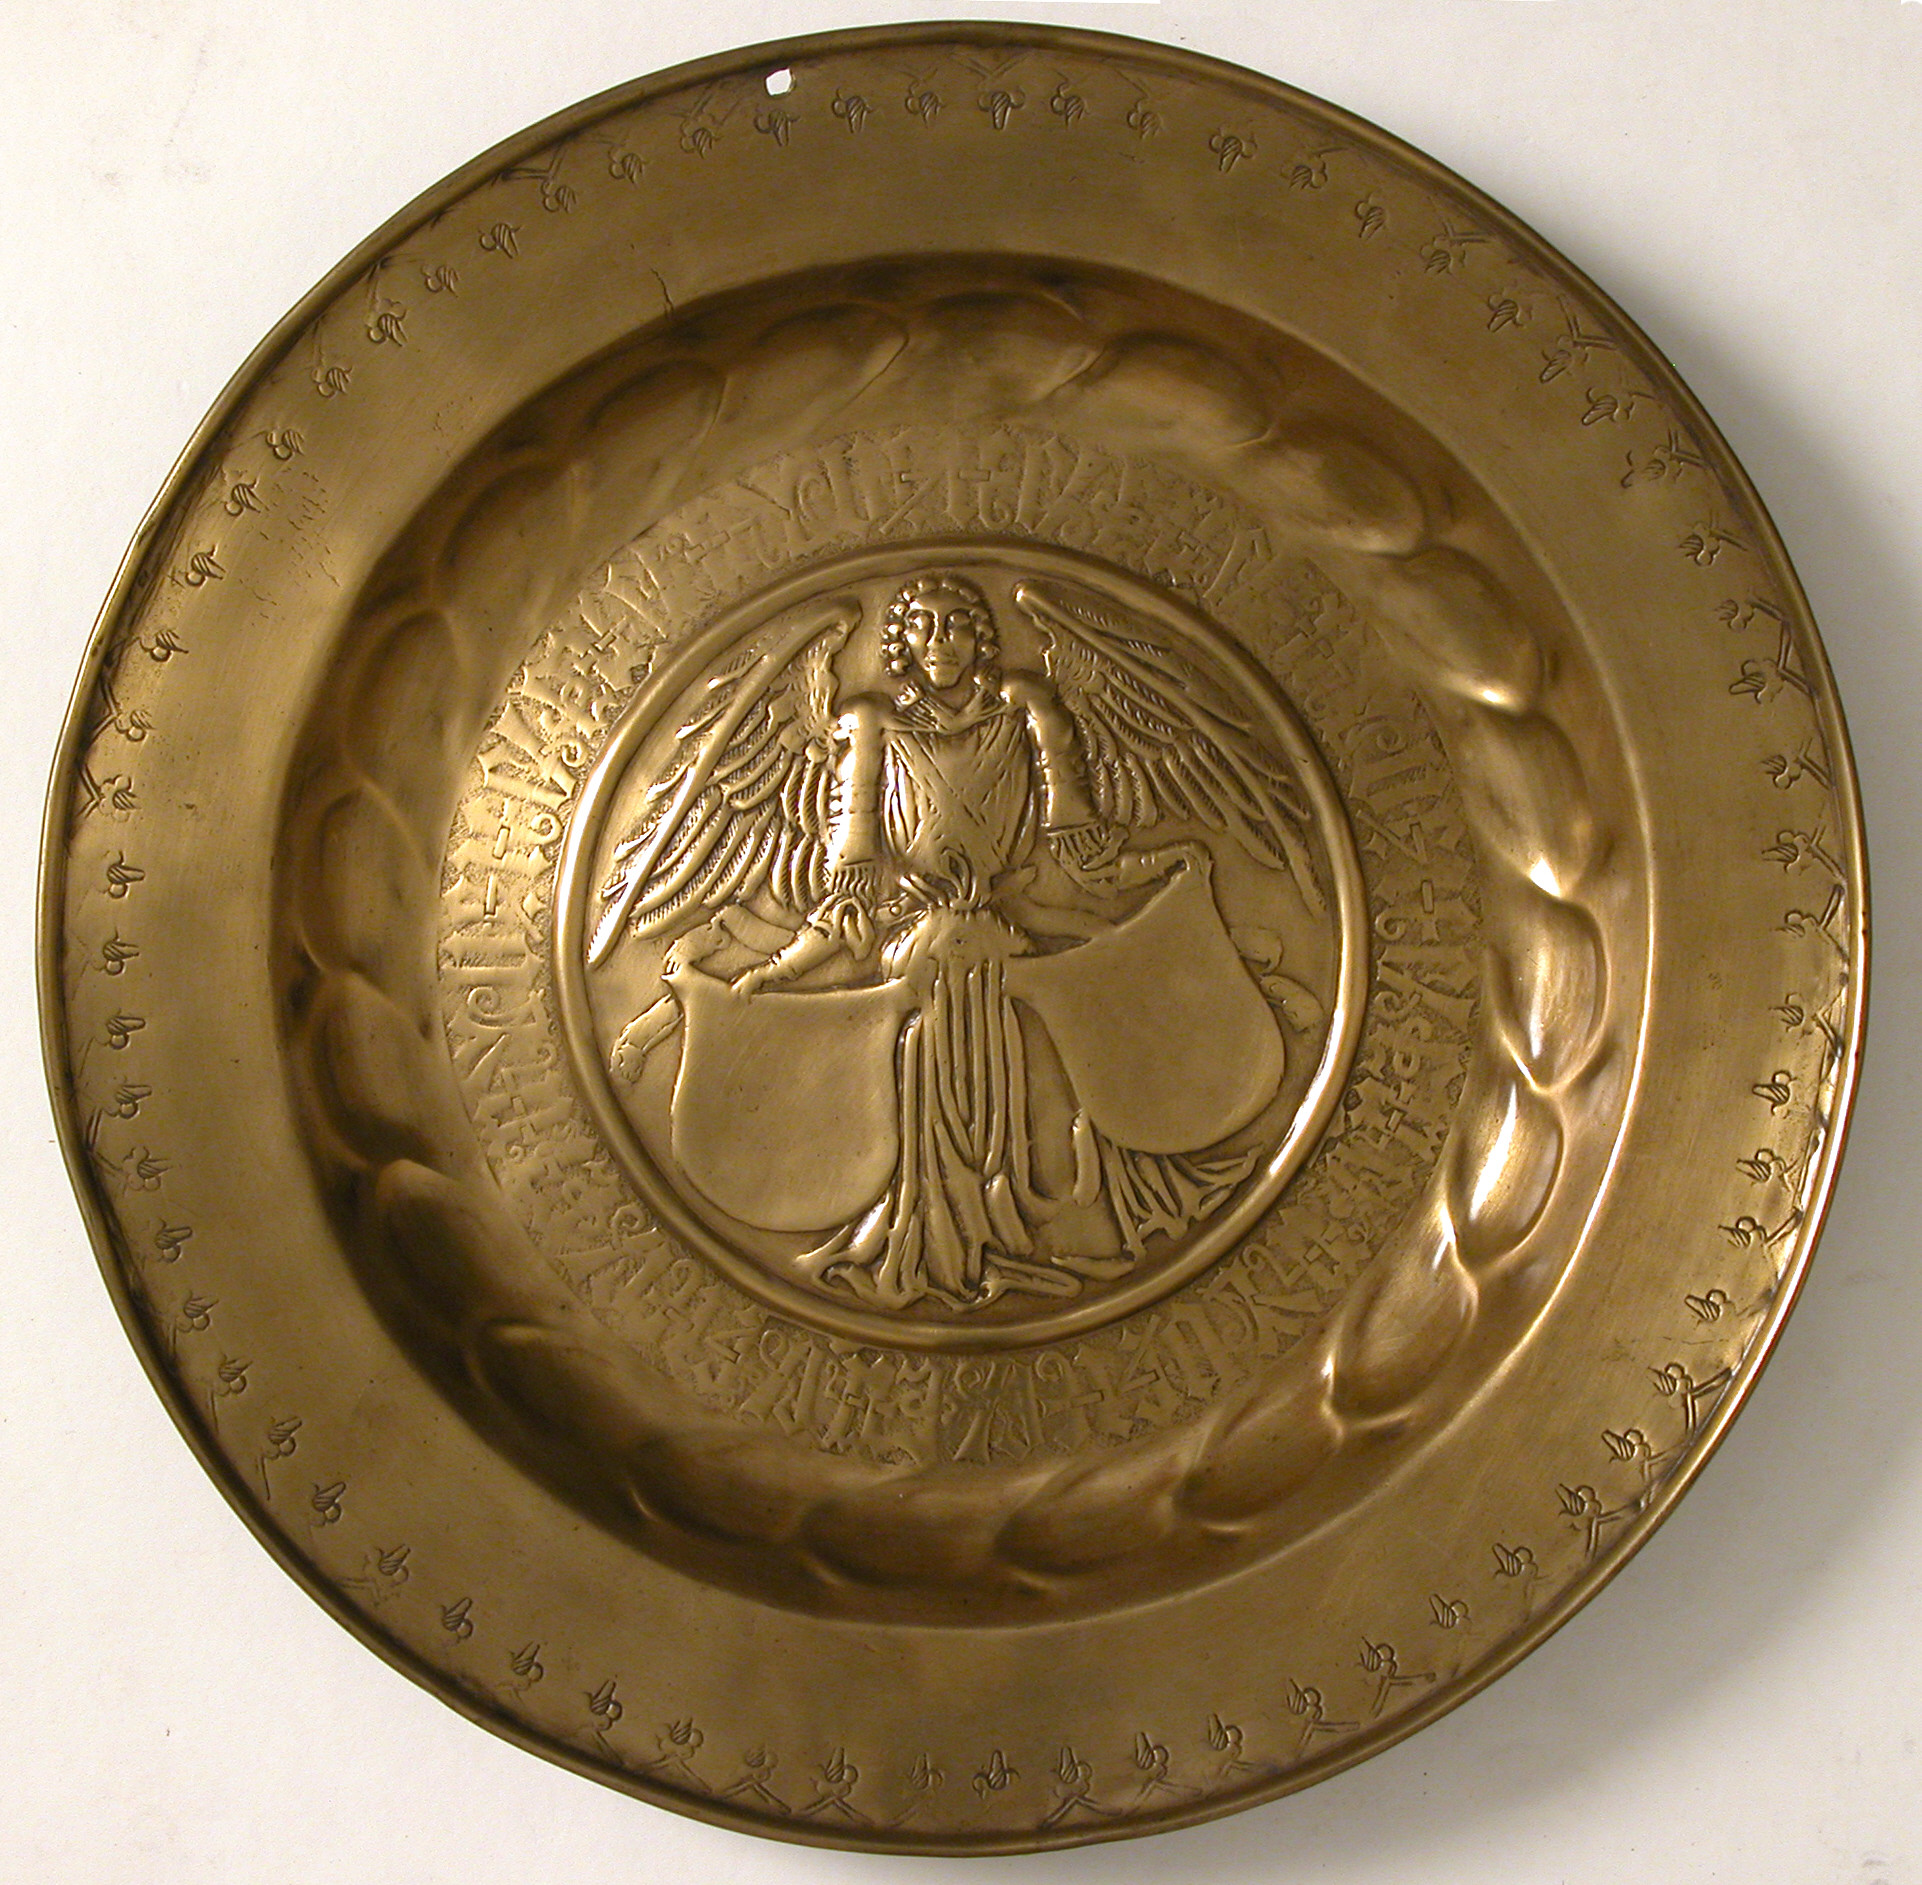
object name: dish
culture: german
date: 1501-1533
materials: brass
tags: shields,angels